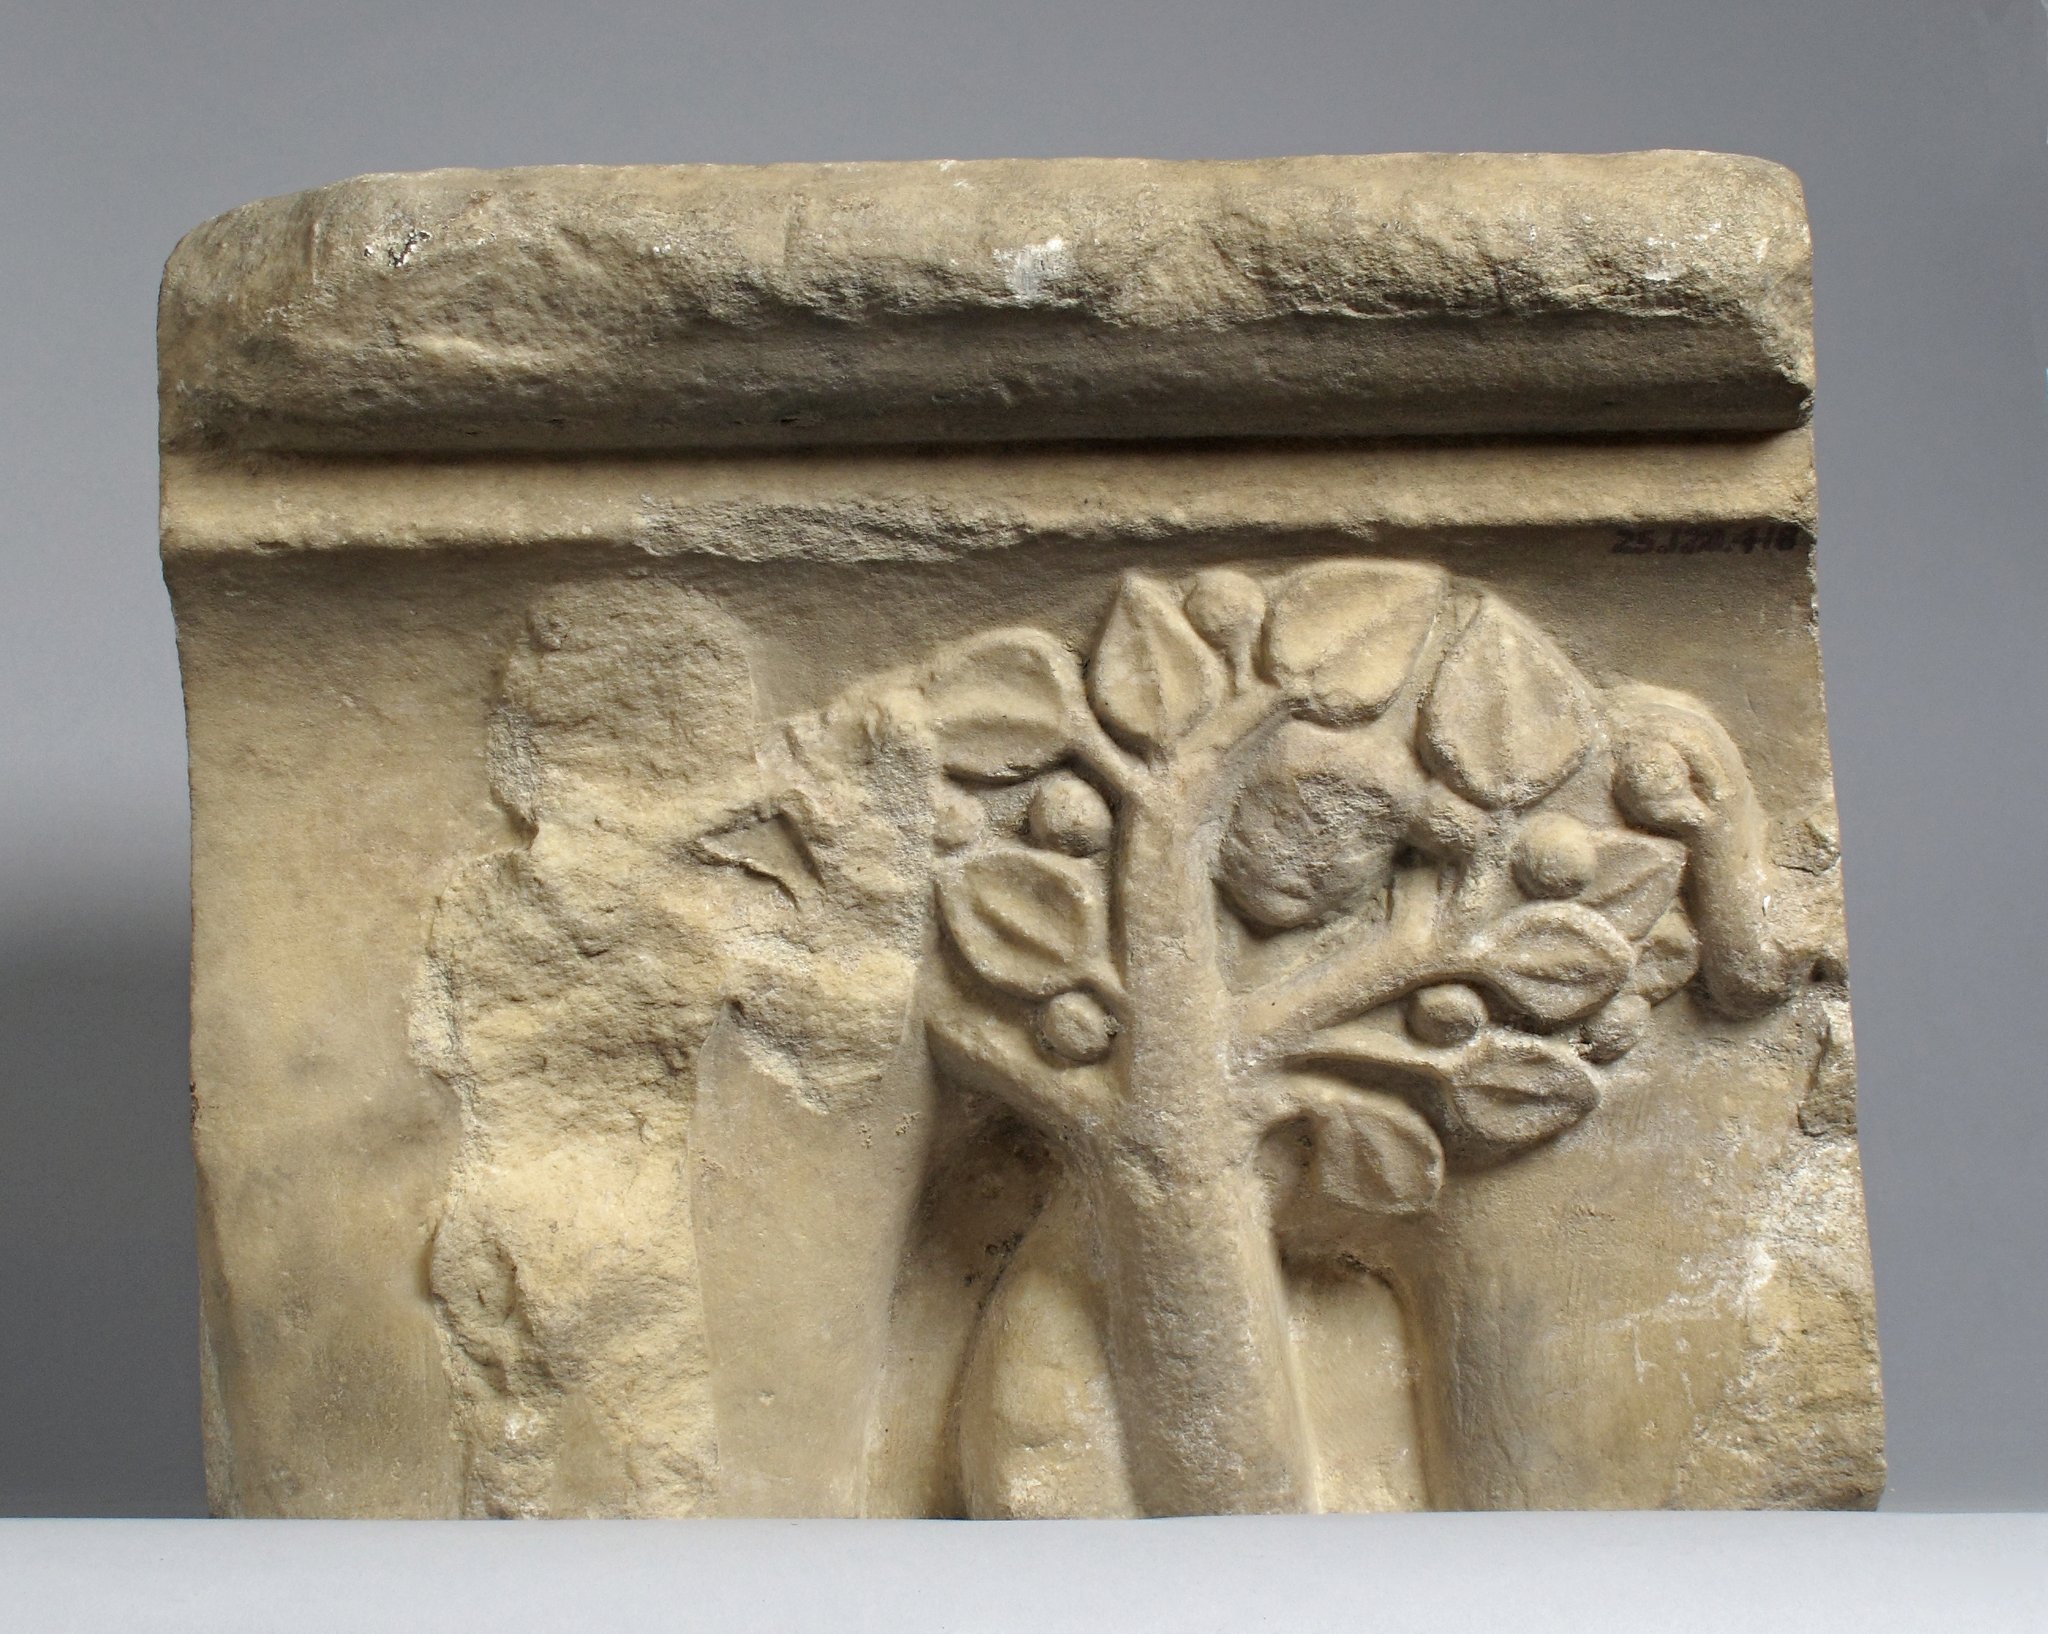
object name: capital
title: Double Capital Fragment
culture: french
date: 1467-1500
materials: stone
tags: trees